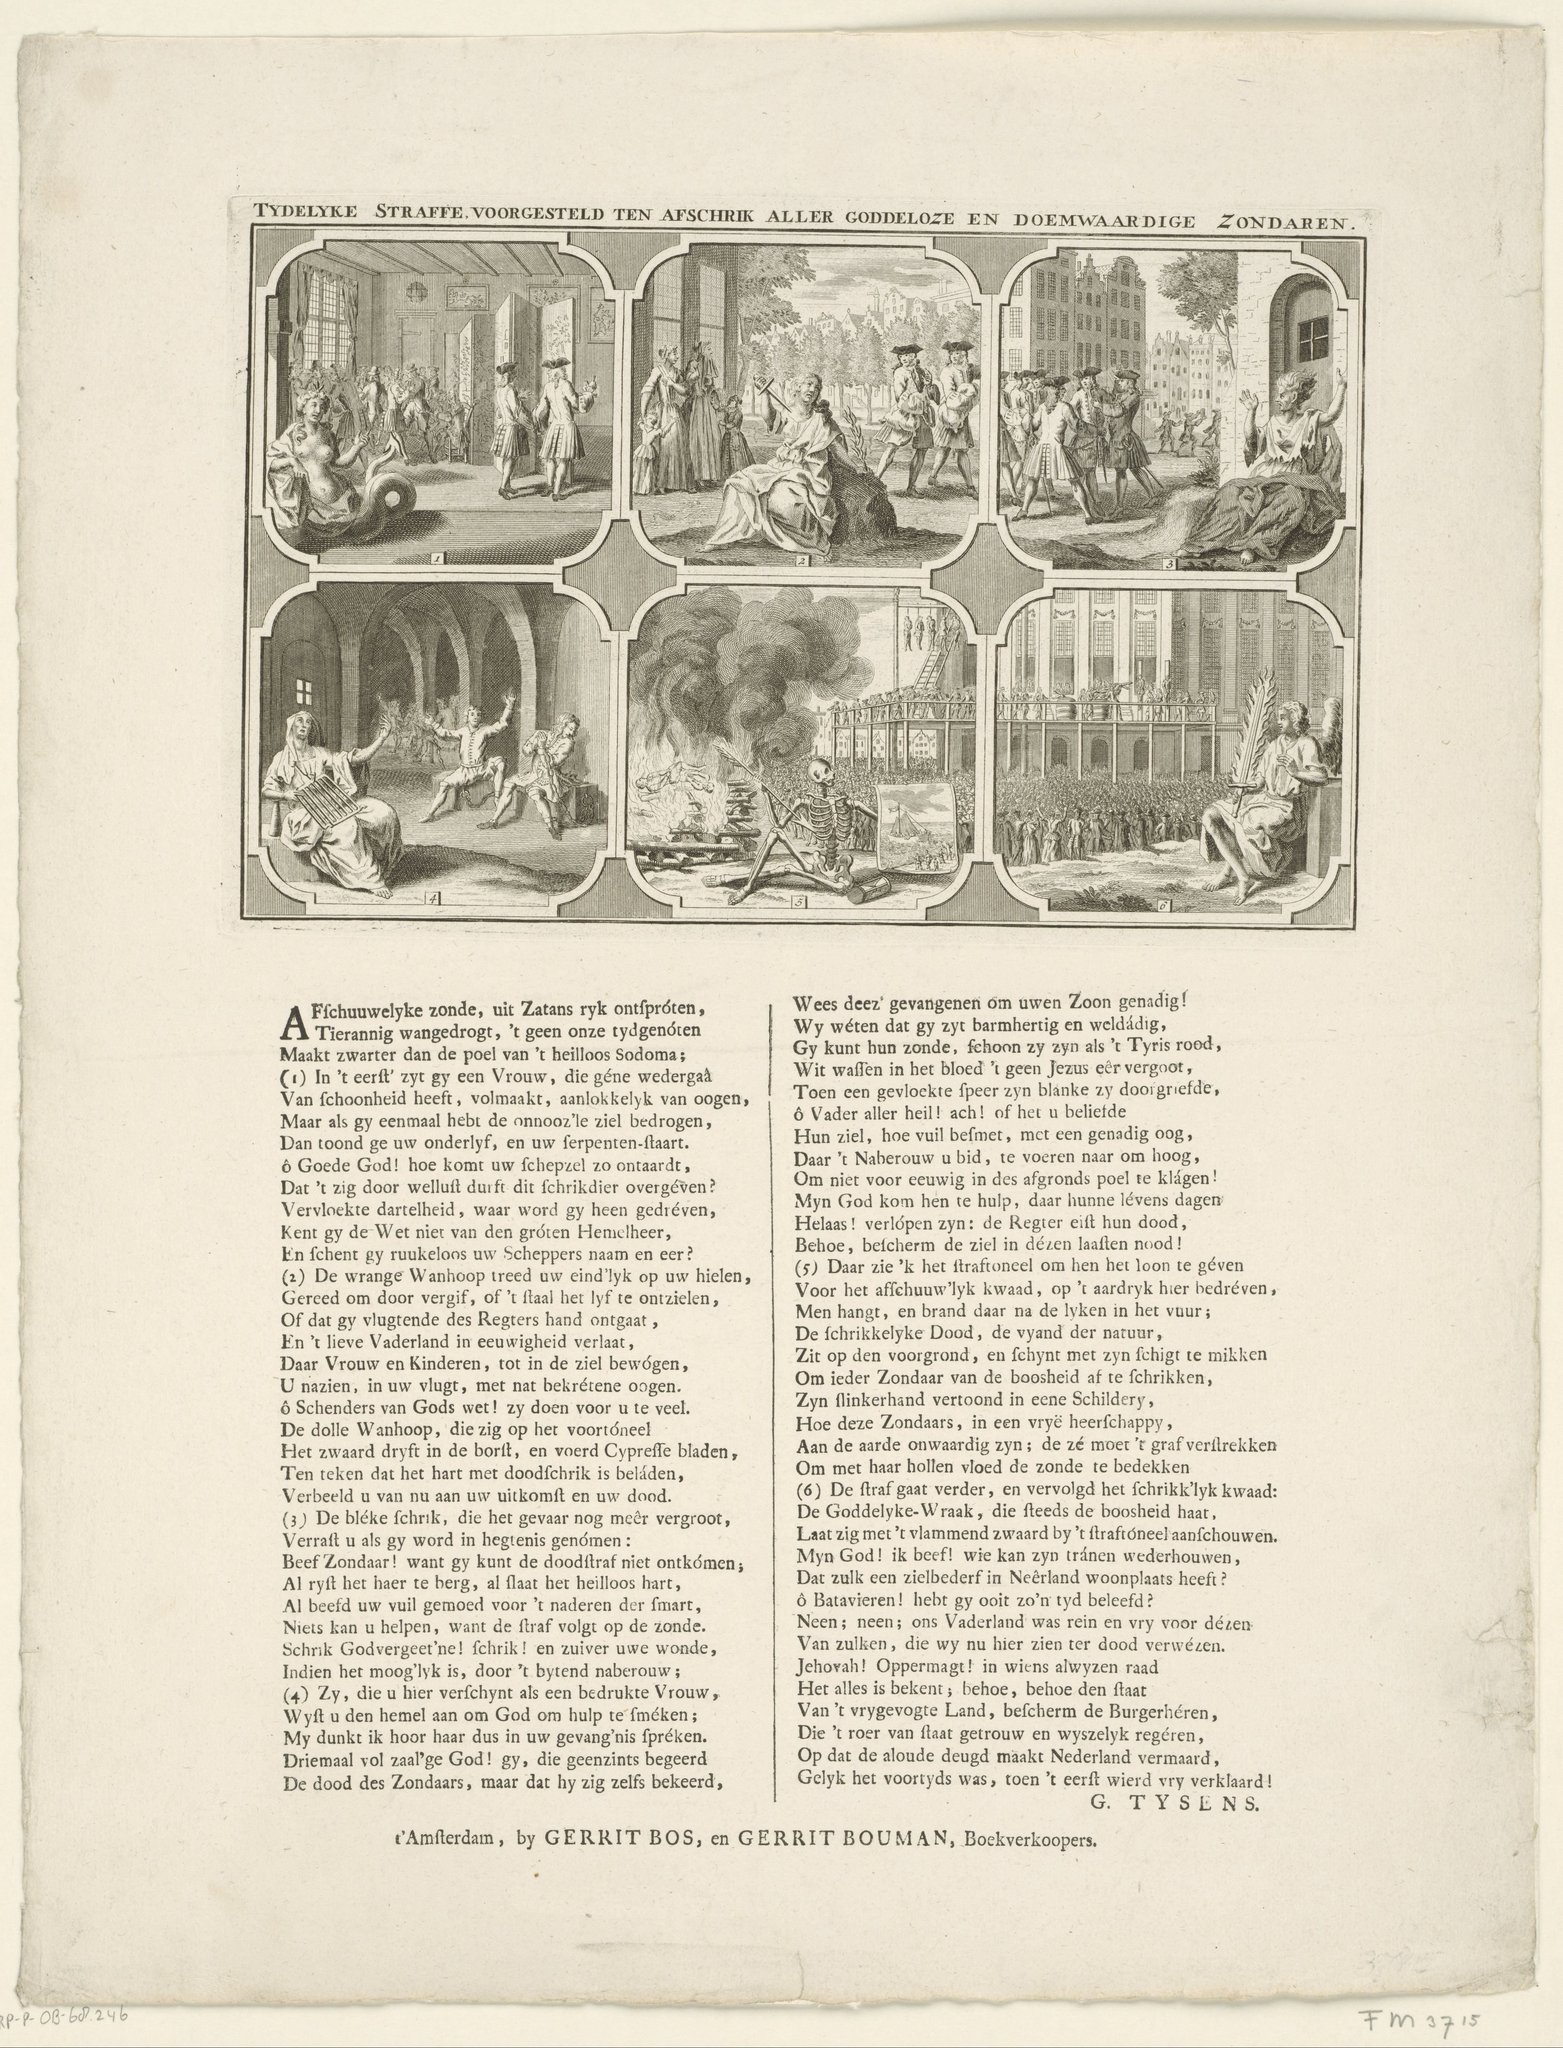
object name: print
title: Vervolgen en straffen van homoseksuelen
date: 1730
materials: paper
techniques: etching, letterpress printing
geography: amsterdam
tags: sodomy, sexual contact between men, law and jurisprudence (+ public punishment), law and jurisprudence (+ imprisonment), violent death by hanging, drowning (violent death ~ water), man as sinner, the hague, amsterdam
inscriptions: address: ‘t'Amsterdam, by GERRIT BOS, en GERRIT BOUMAN, Boekverkoopers’, poem: ‘Afschuuwelyke zonde, uit Zatans ryk ontsproten...Gelyk het voortyds was, toen 't eerst wierd vry verklaard !’, signature: ‘G. TYSENS’